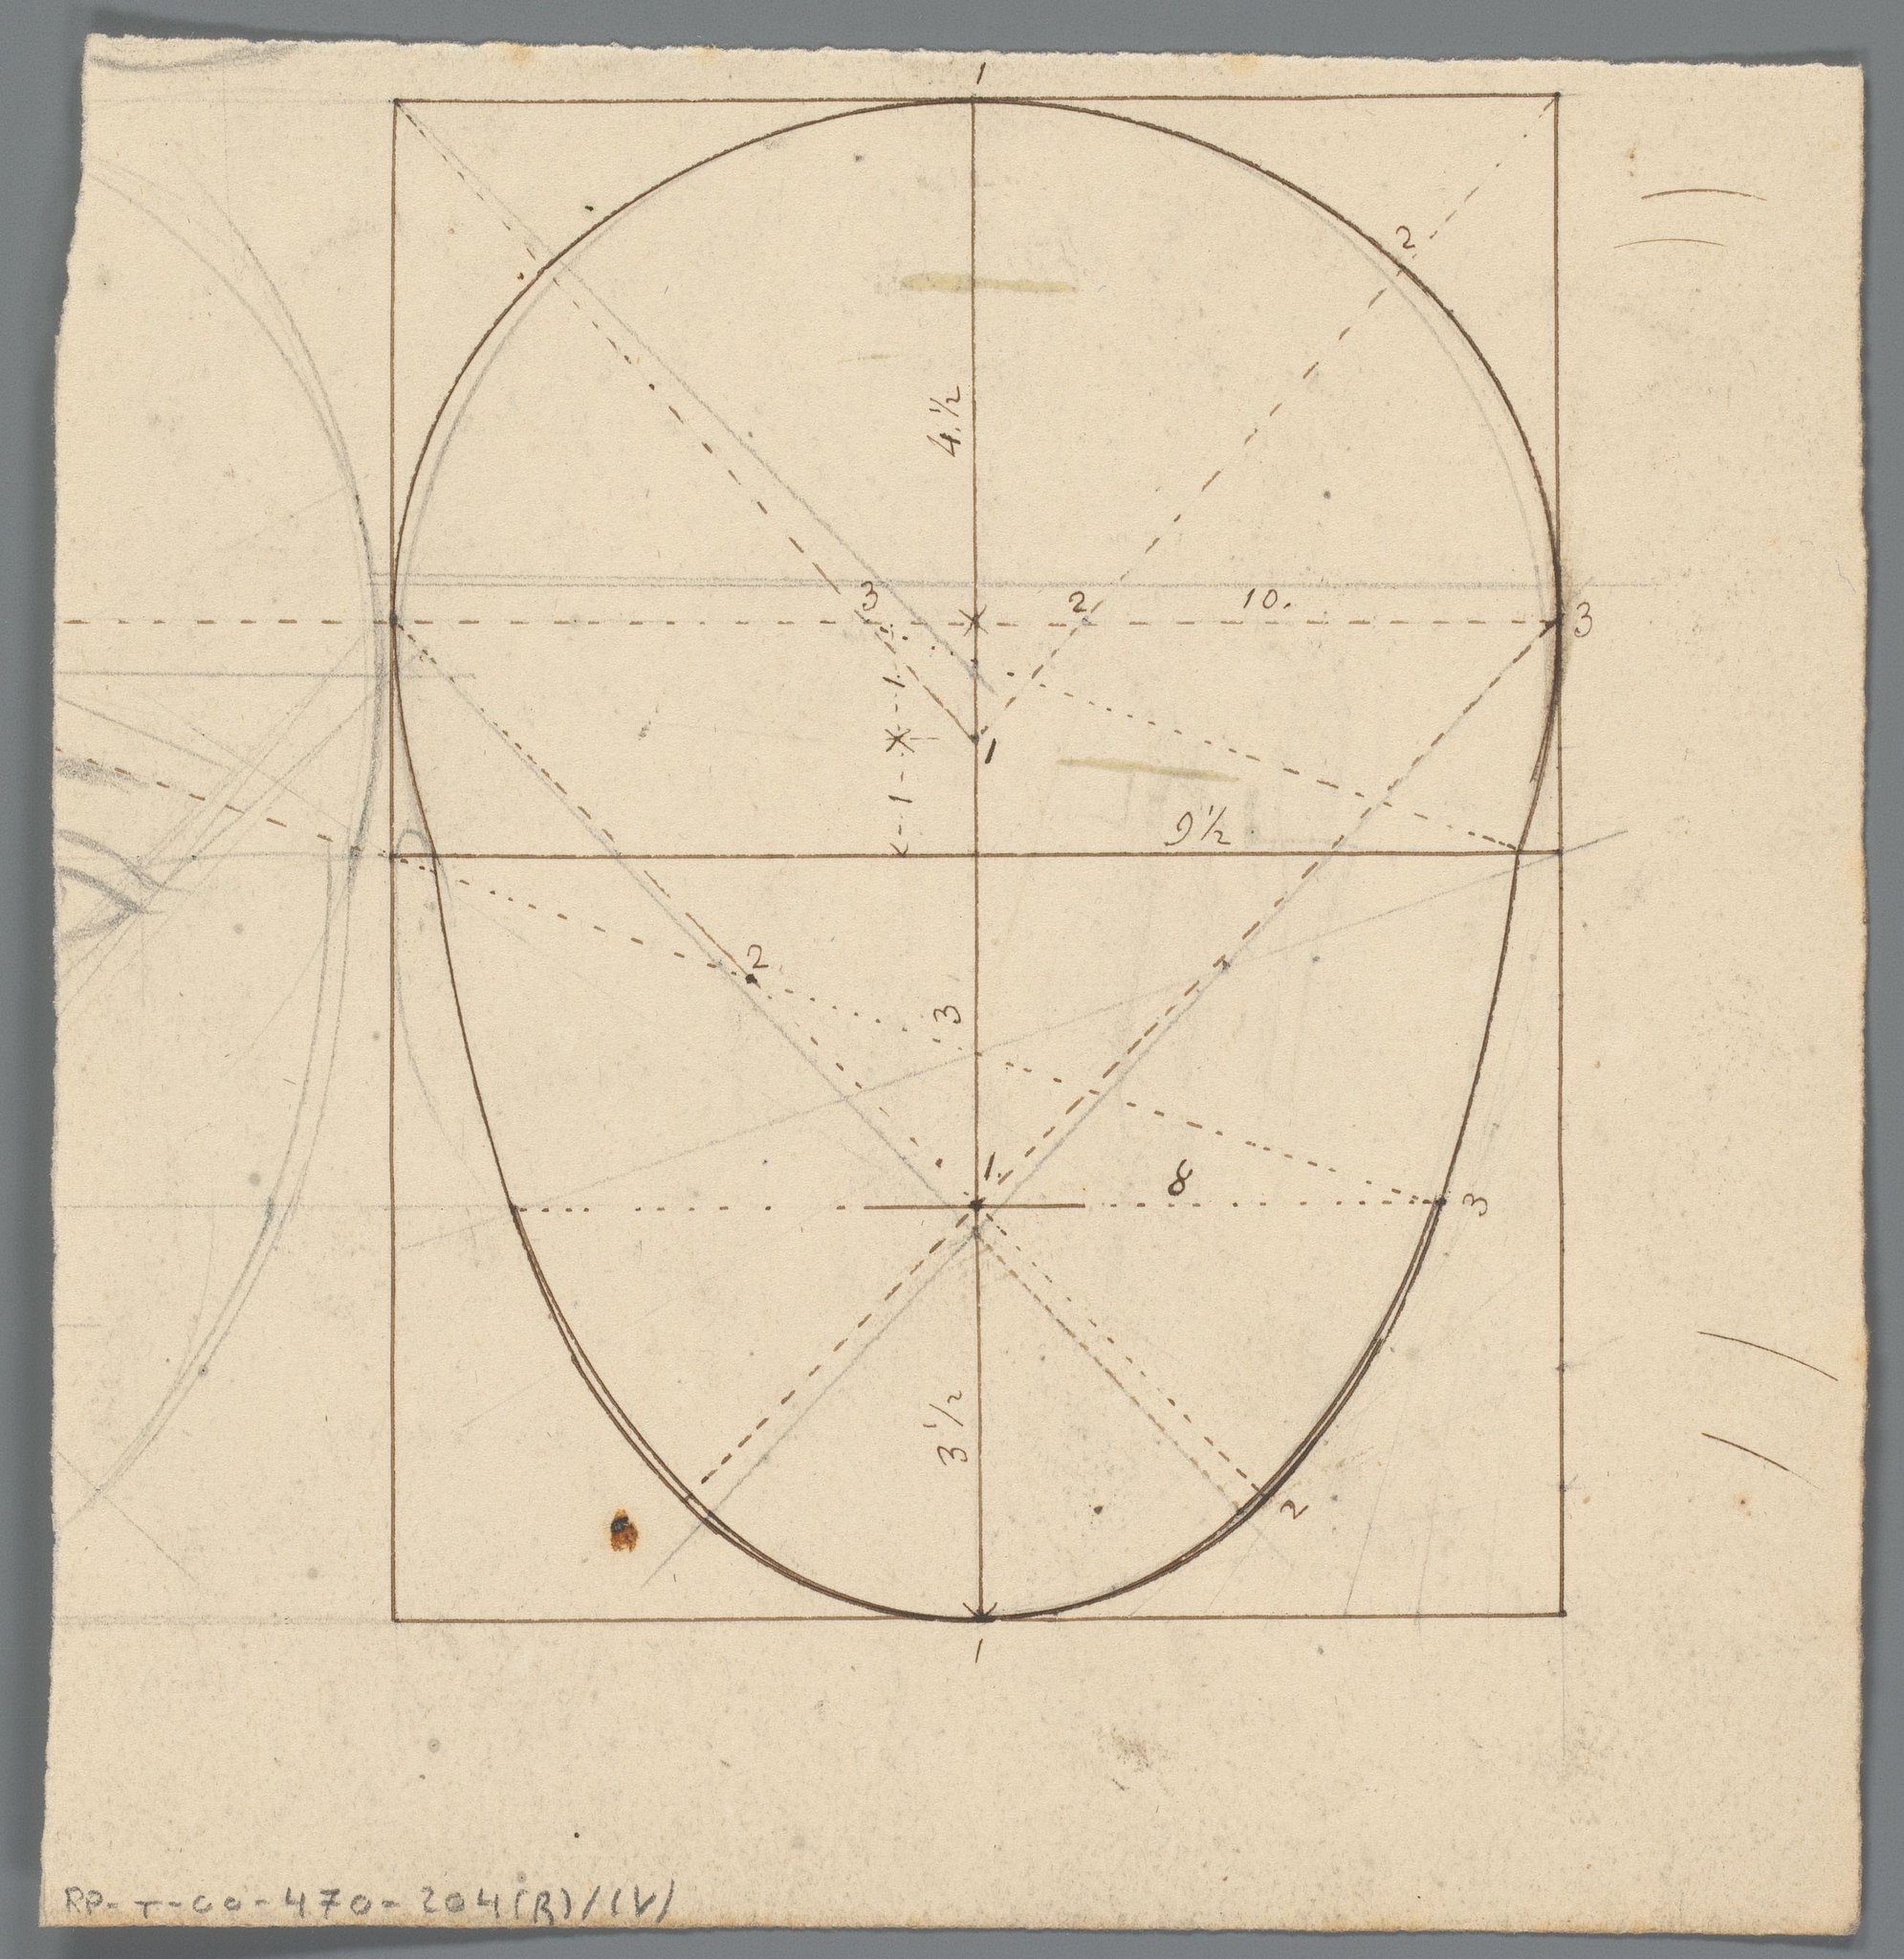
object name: drawing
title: Proportiestudie van een hoofd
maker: jacobus everhardus josephus van den berg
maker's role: draughtsman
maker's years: 1802-1861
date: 1812-1861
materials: ink, paper, pencil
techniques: pen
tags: head (human)